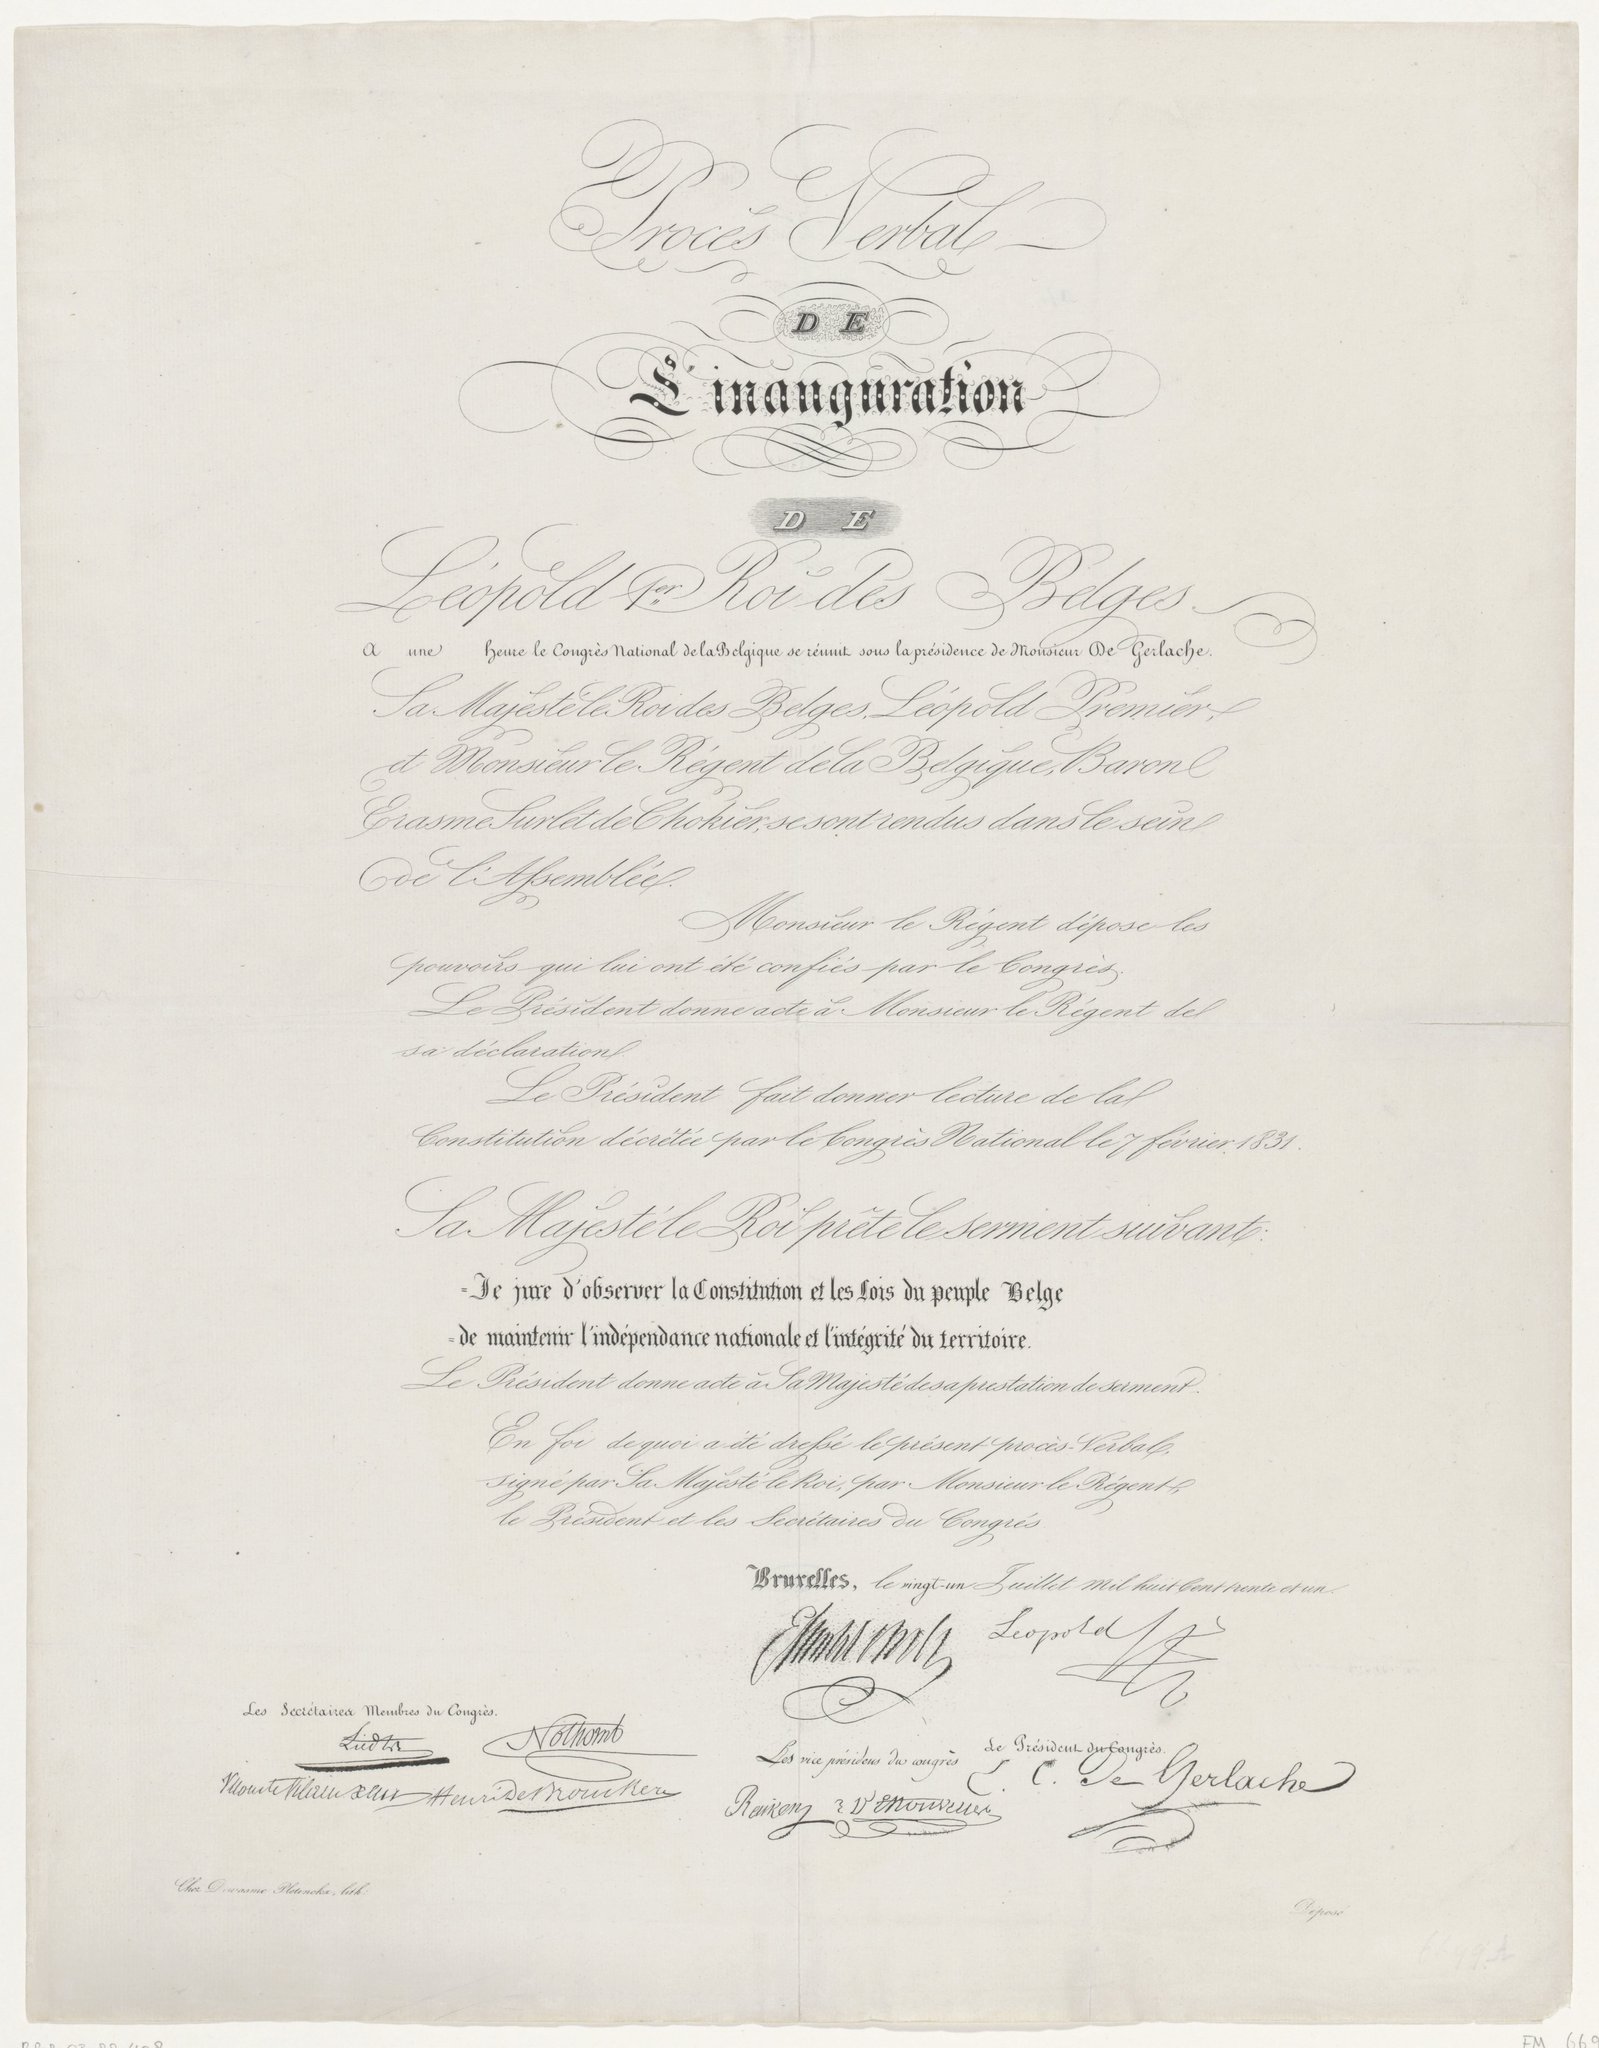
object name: print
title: Proces Verbale de L'inauguration de Léopold 1er Roi des Belges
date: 1831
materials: paper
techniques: lithograph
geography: belgium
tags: politician, laeken, leopold i (koning der belgen), other forms of installation, brussels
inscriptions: collector's mark: Lugt 2228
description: Proces-verbaal van de inhuldiging van koning Leopold I in Brussel op 21 juli 1831. Schriftelijke weergave van de onderdelen van de ceremonie en de tekst van de eed afgelegd door de koning. Onderaan de handtekeningen van de regent, de koning en leden van het Nationaal Congres.